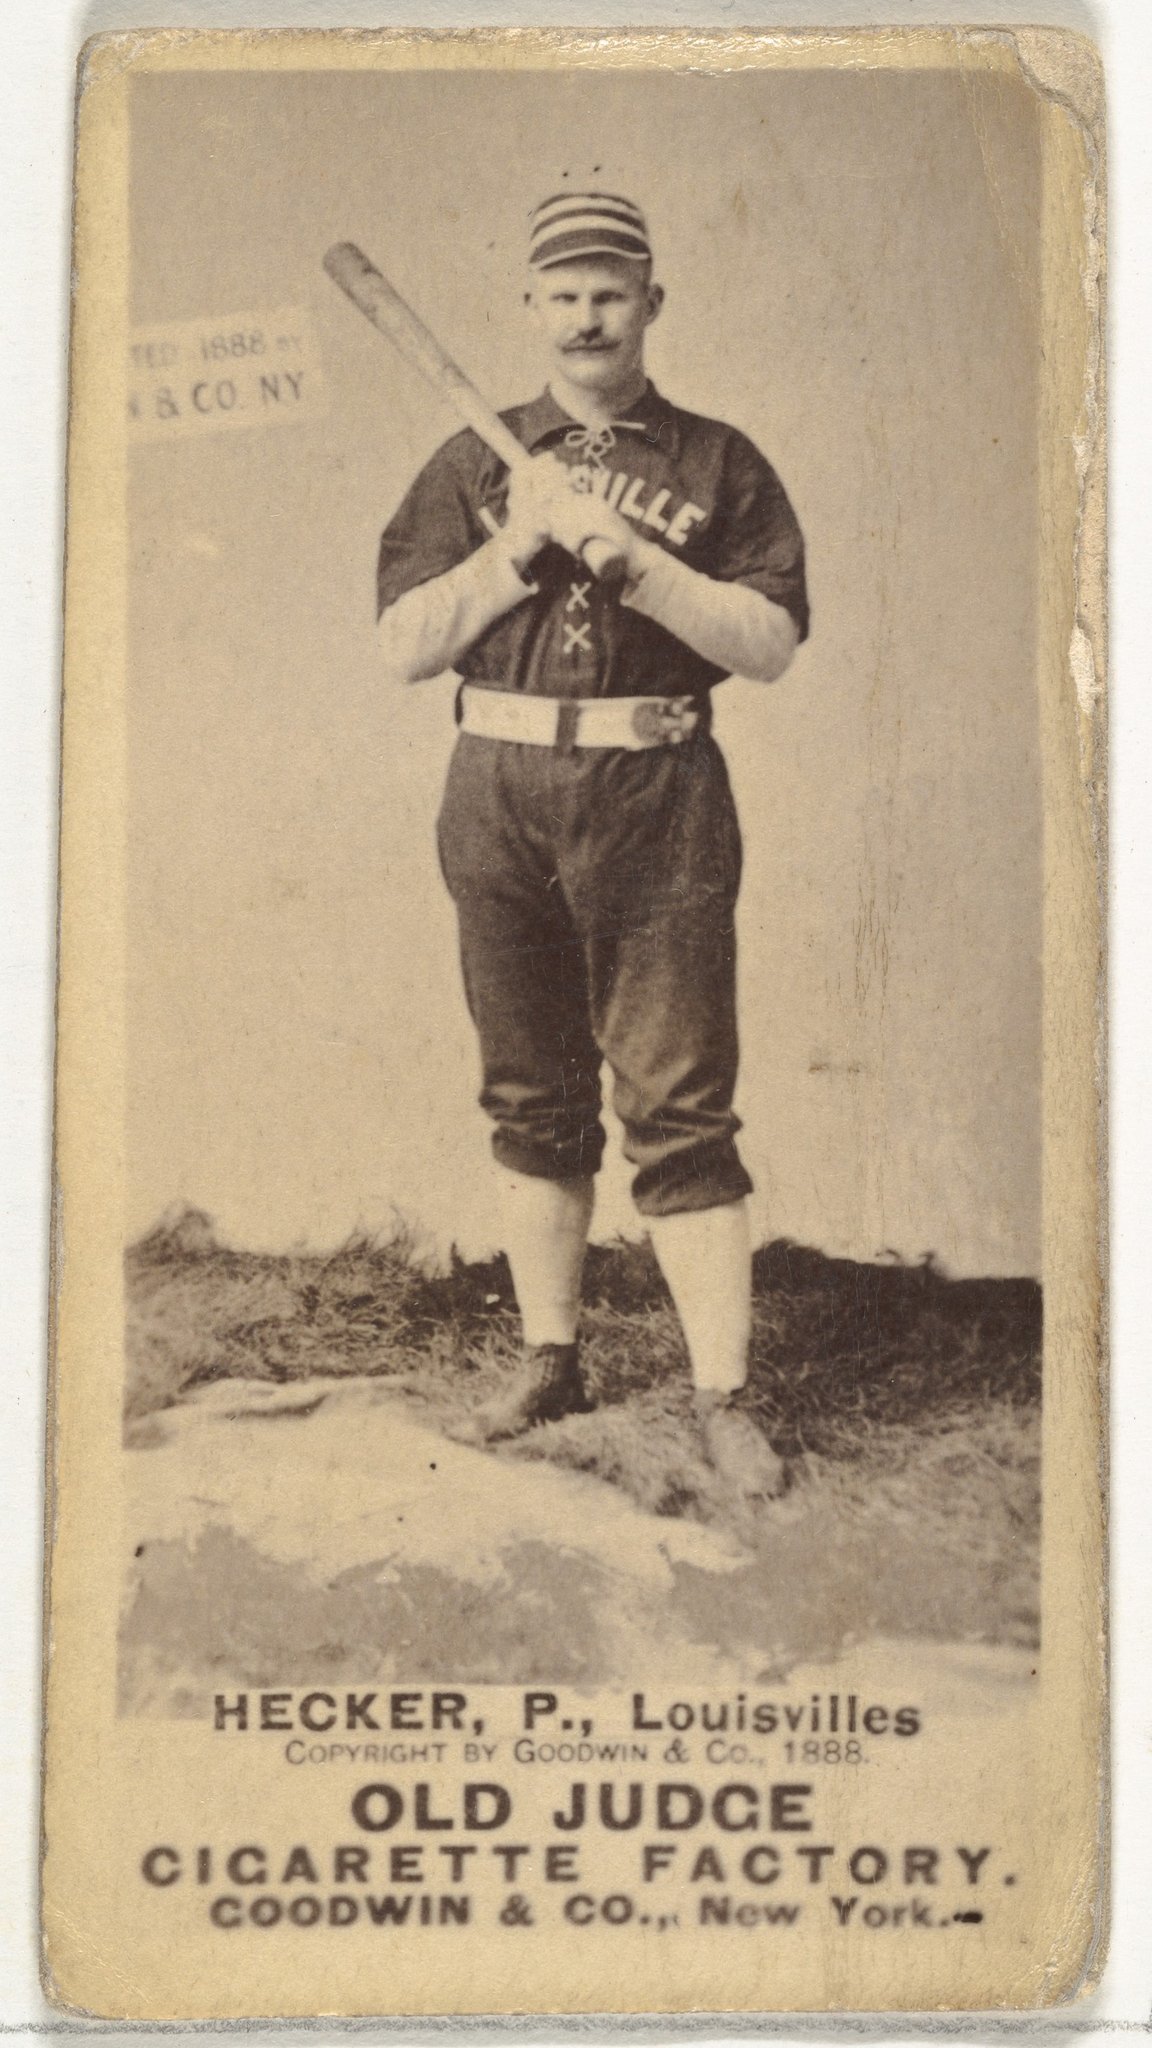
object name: baseball card, photograph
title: Guy Jackson Hecker, Pitcher, Louisville Colonels, from the Old Judge series (N172) for Old Judge Cigarettes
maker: goodwin & company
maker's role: publisher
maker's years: 1850-1950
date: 1888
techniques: albumen silver print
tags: men,portraits,baseball,athletes